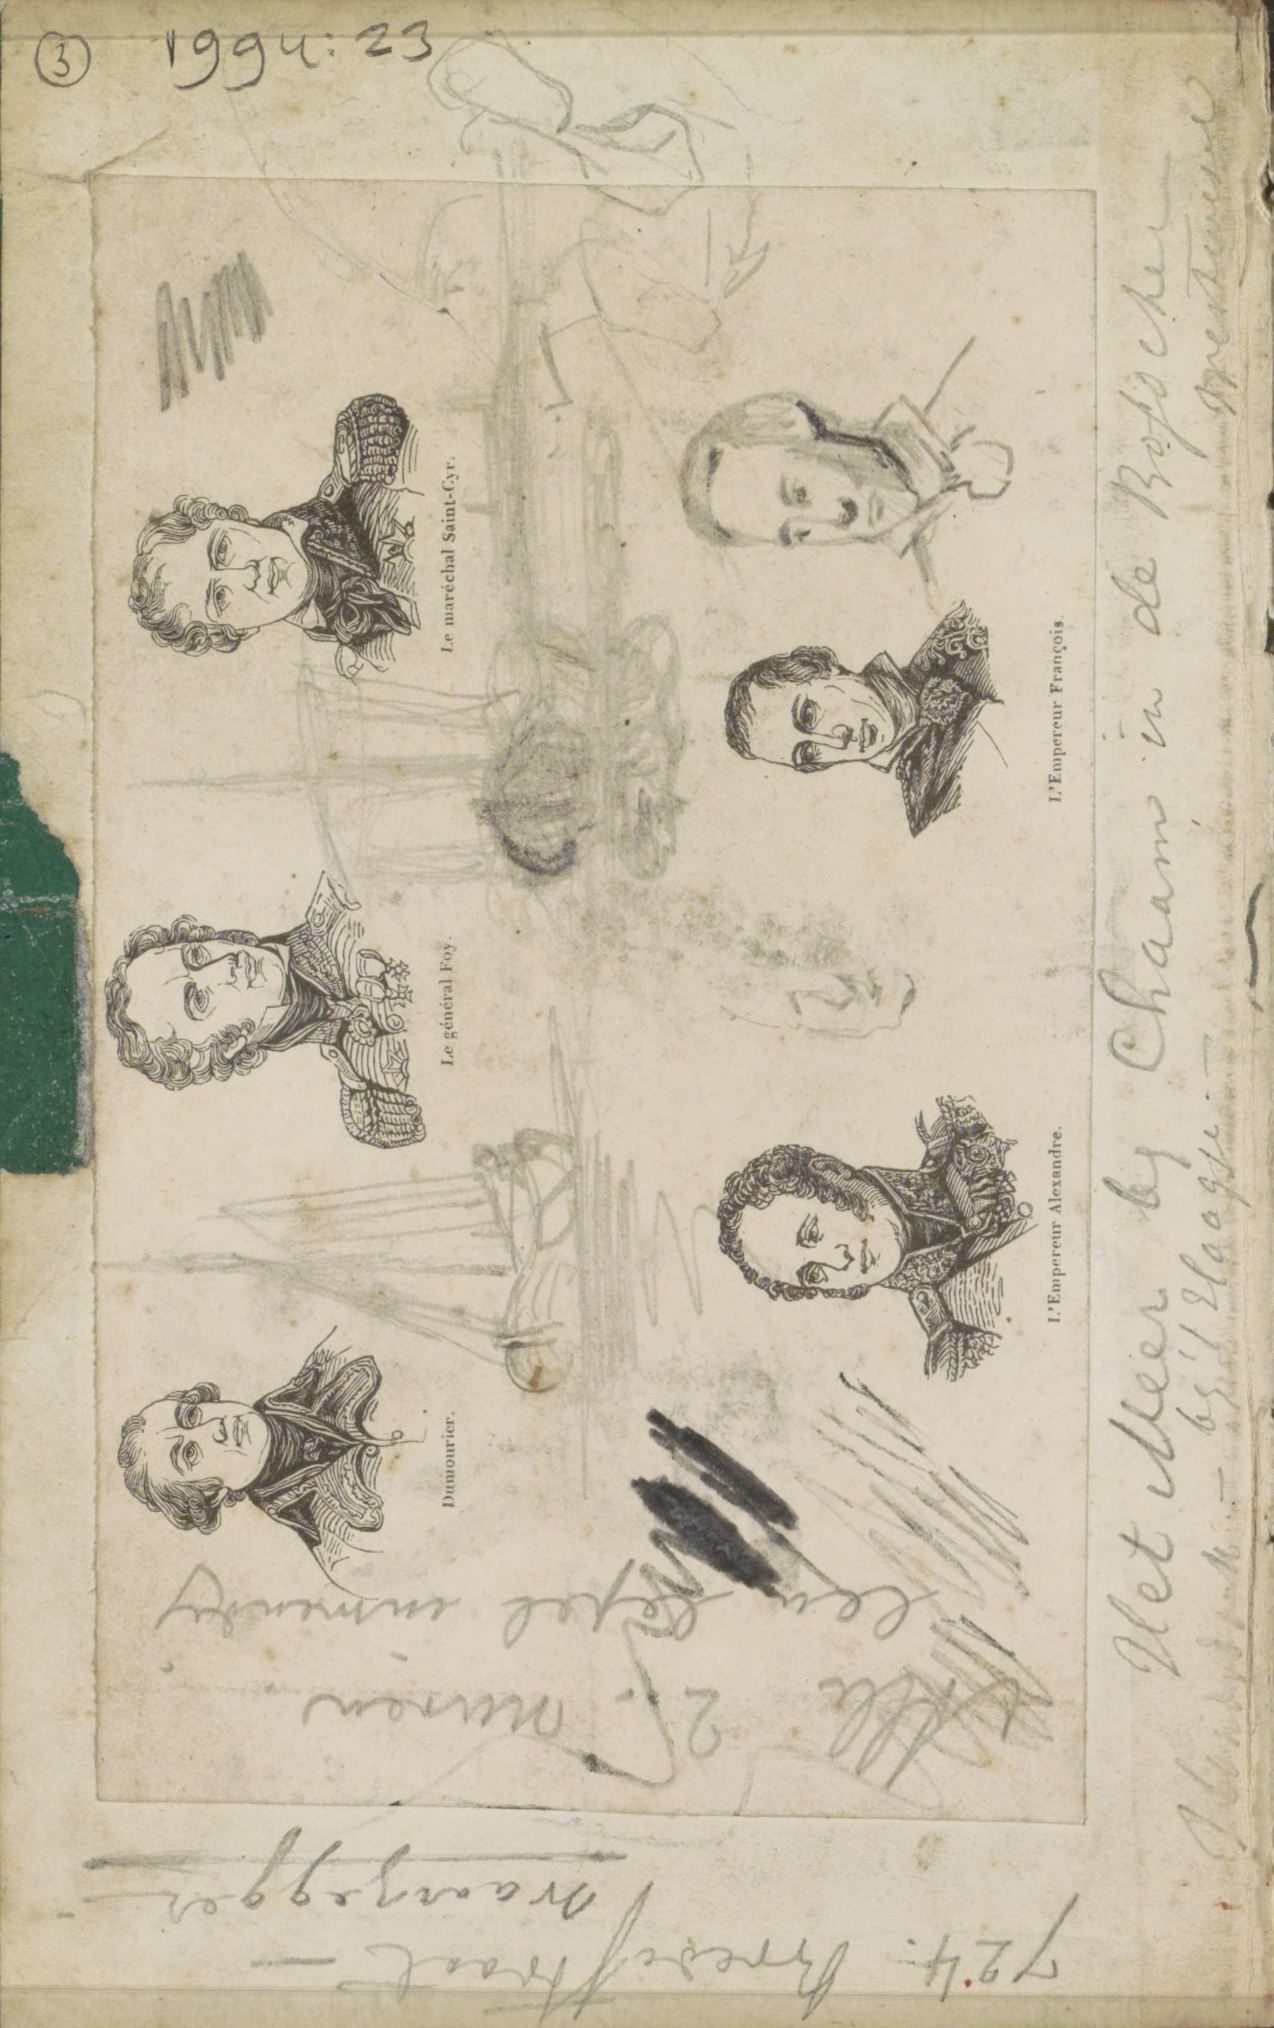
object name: sketchbook leaf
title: Zeilschepen op het meer bij Chaam in Brabant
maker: johannes tavenraat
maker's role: draughtsman, painter, print maker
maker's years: 1809-1881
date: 1839-1872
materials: paper, pencil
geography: chaam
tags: head (human), sailing-ship, sailing-boat, lake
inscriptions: annotation: ‘724 Brede Straat/ waarzegger/ Alle 2 muren/ een lepel inmendy/ Het meer bij Chaam in de Bosschen/ [...] bij 't Haagje [...]’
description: Tevens een mansportret en portretten op een uitgeknipte en in het schetsboek geplakte prent van Franse militaire leiders, waaronder L'Empereur François en L'Empereur Alexandre. Voorste schutblad uit een schetsboek met 73 bladen.